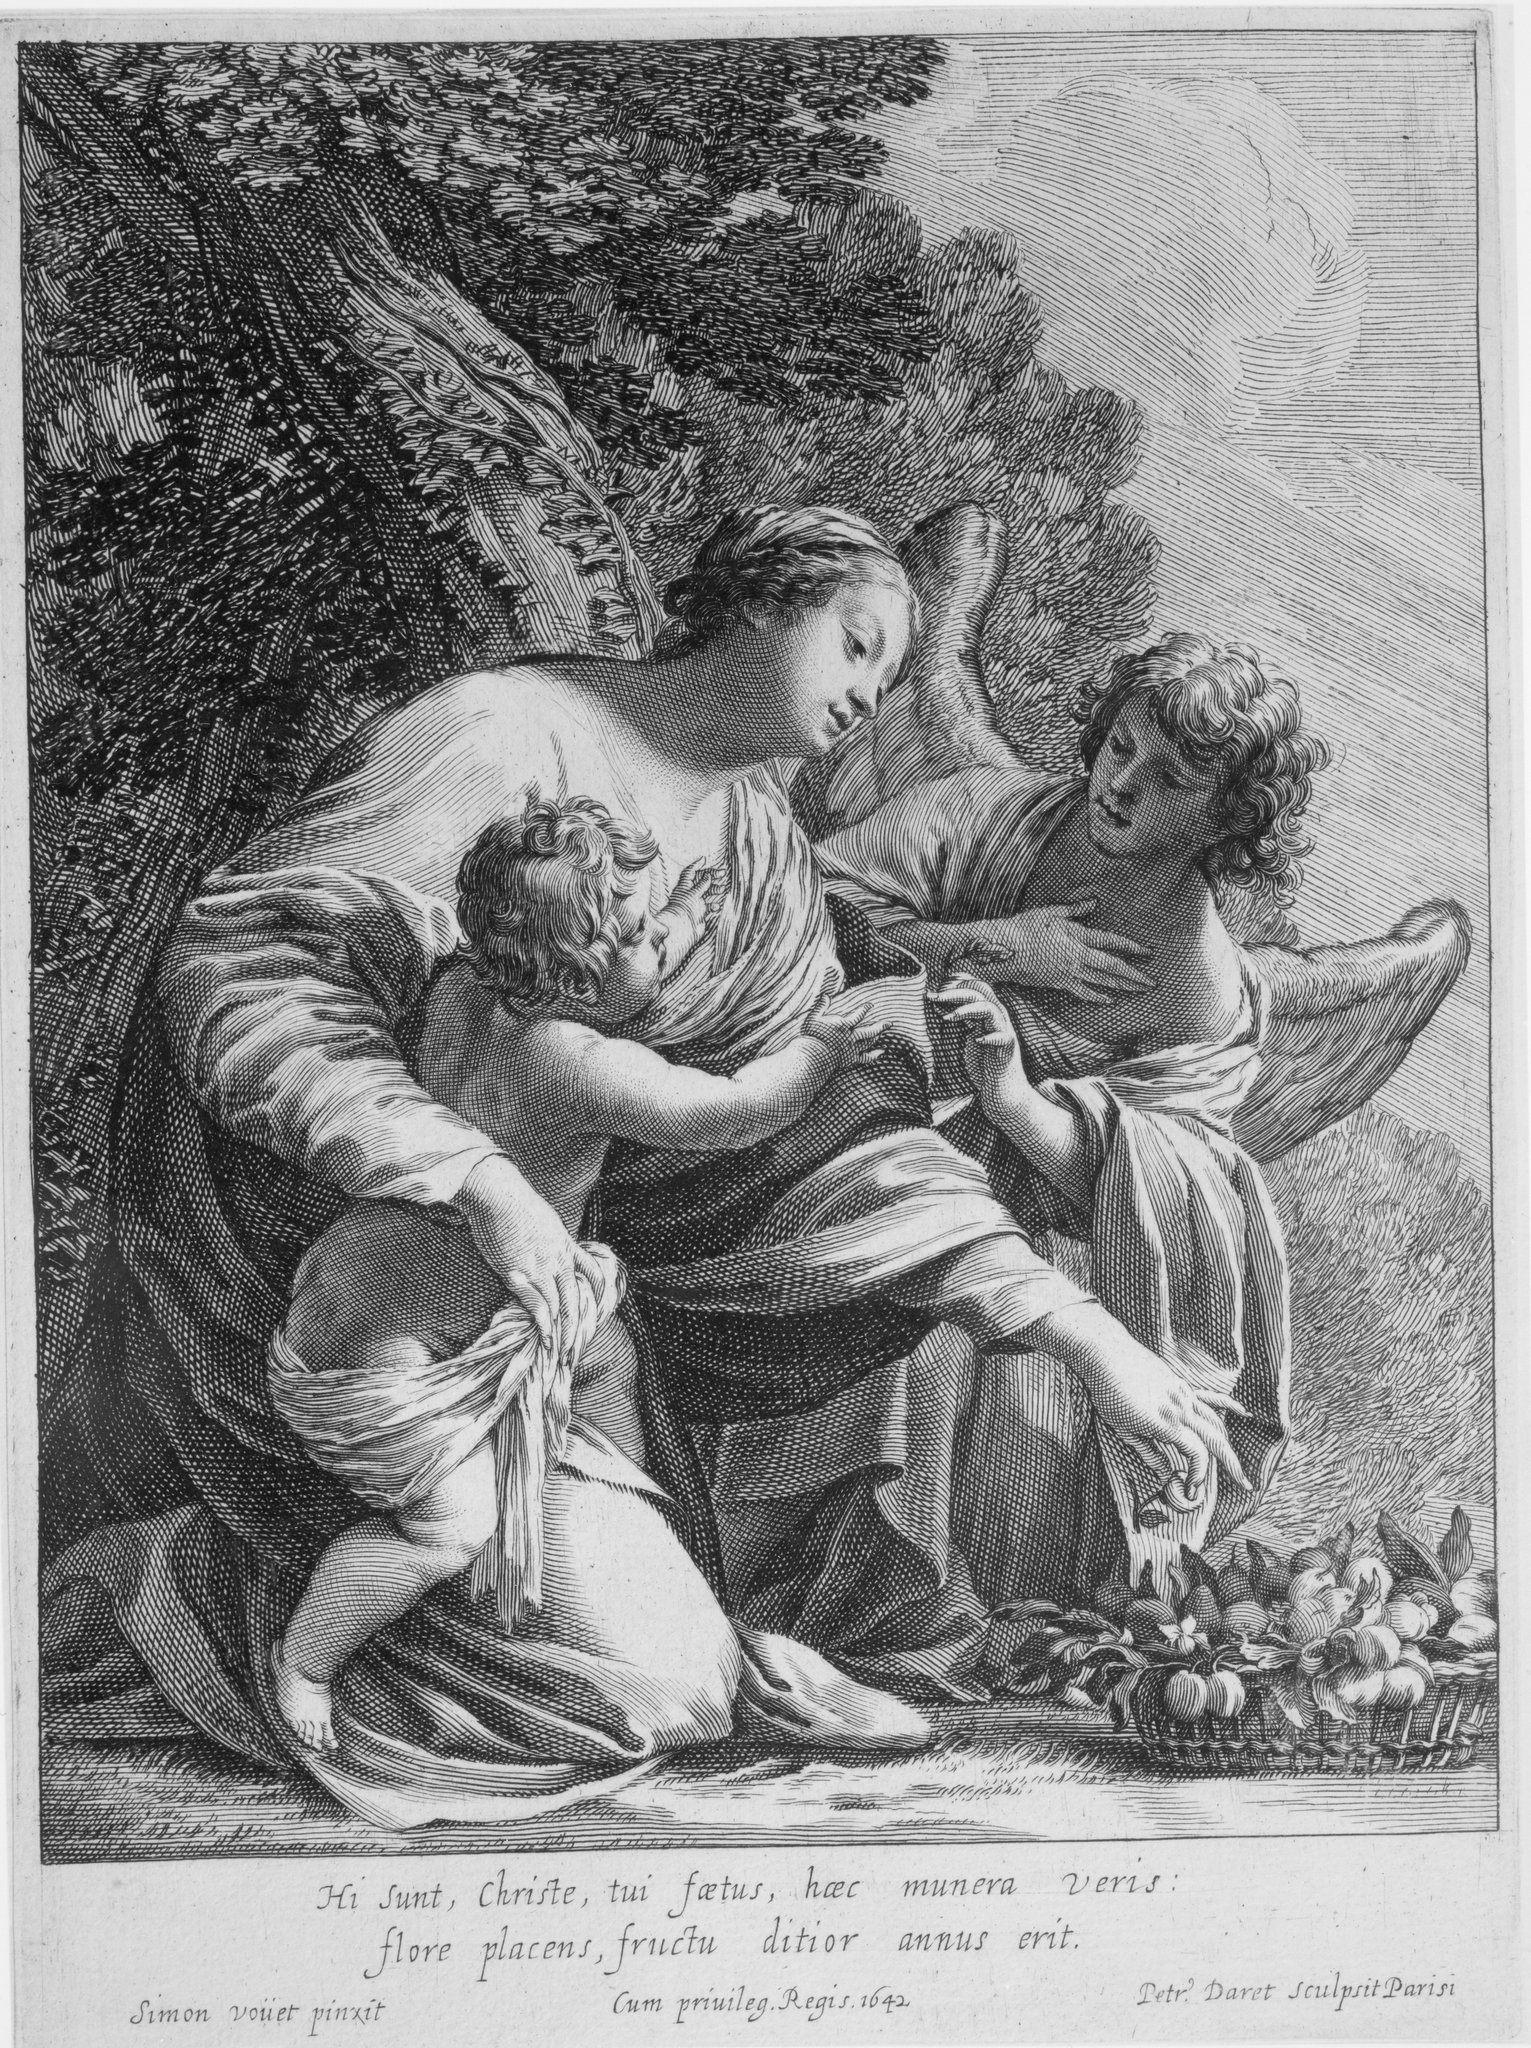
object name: book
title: Scrapbook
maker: simon vouet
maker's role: artist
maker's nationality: french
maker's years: 1590-1649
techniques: engraving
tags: children,women,angels